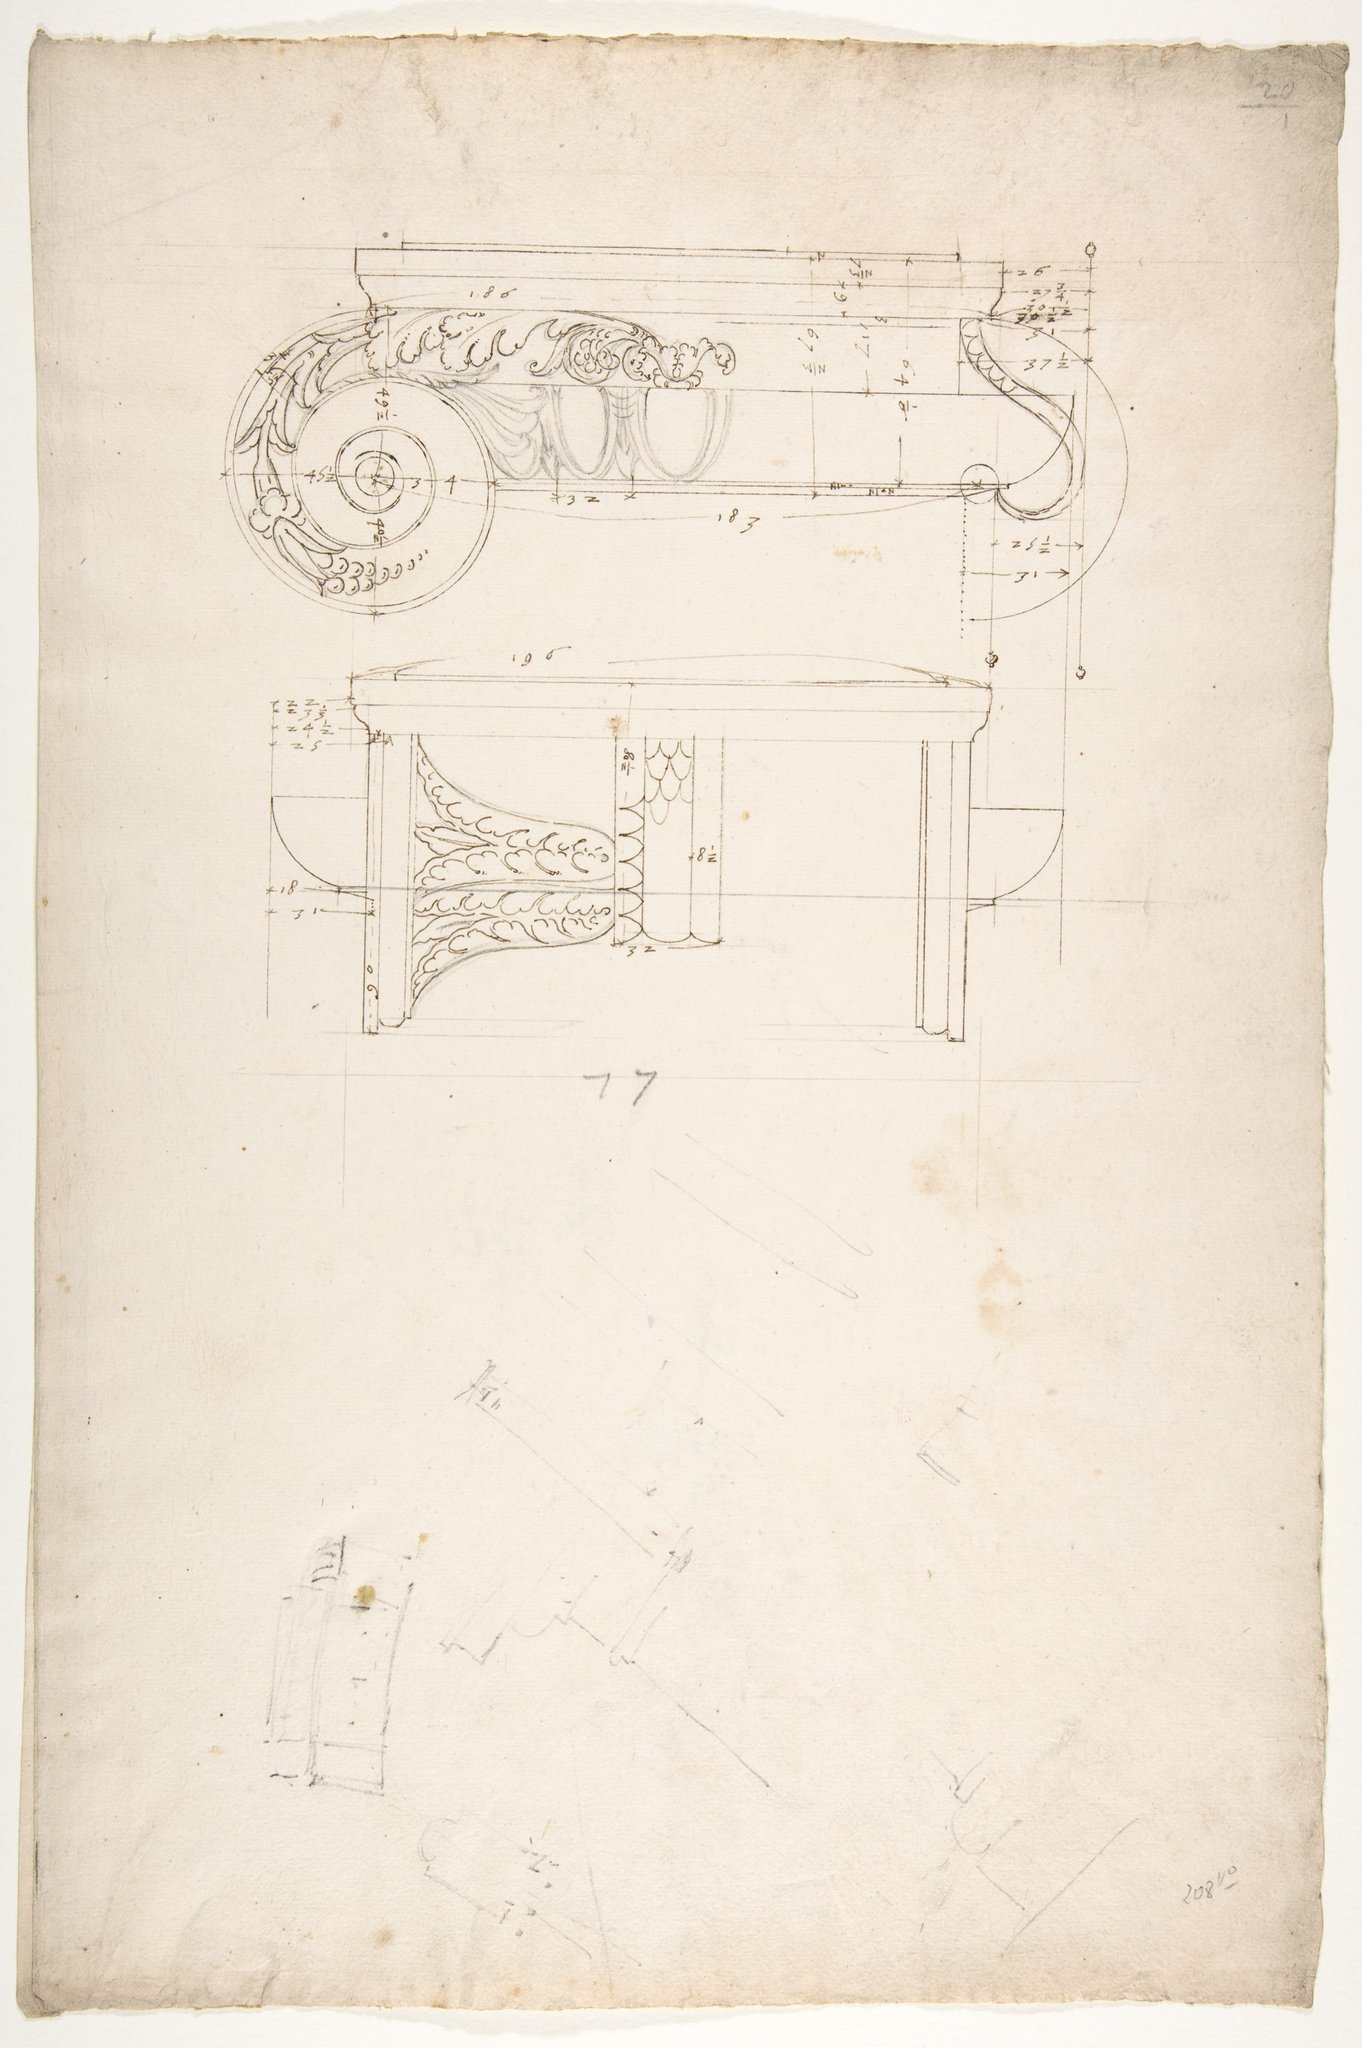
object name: collection ornament architecture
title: Unidentified, Ionic capital, front and side elevations with small studies (recto) calculation notes (verso)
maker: anonymous, french, 16th century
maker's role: draftsman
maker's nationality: french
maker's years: 1500-1600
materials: chalk, ink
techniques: incising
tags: capitals